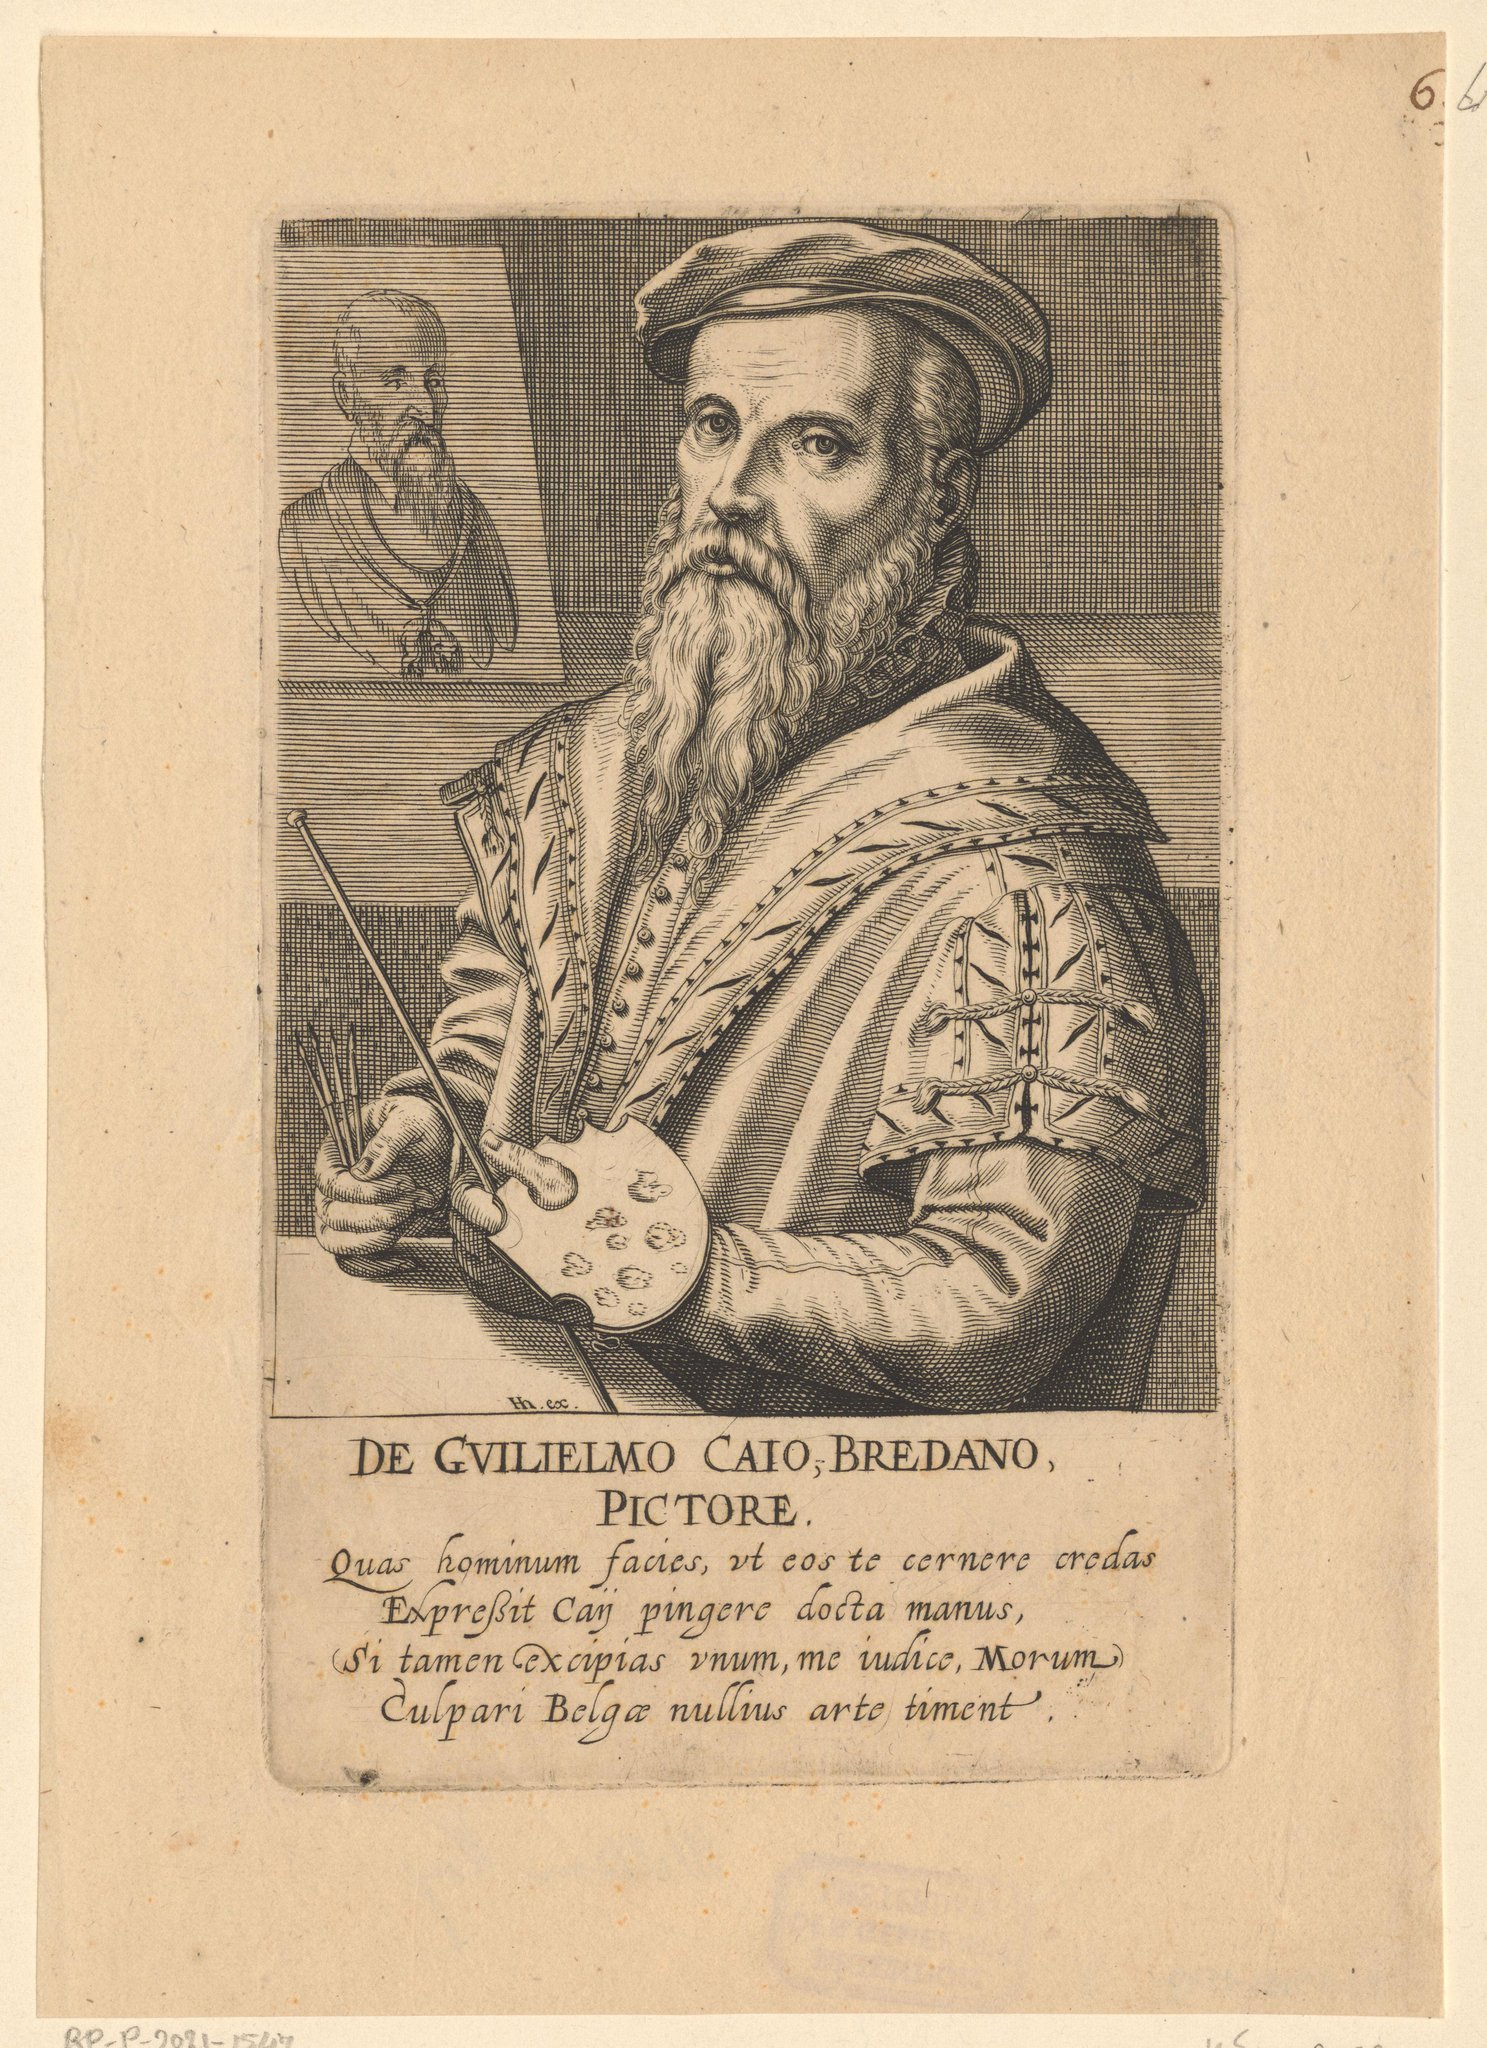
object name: print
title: Portretten van beroemde schilders uit de Lage Landen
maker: hendrick hondius (i)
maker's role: draughtsman, print maker, publisher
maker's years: 1573-1650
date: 1610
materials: paper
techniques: engraving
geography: the hague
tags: antwerp, painter, willem key, historical persons, portrait, self-portrait of painter, tools, implements of painter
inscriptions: collector's mark: Lugt 11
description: Prent uit deel één van de serie Pictorum Aliquot Celebrium Praecipuae Germaniae Inferioris Effigies. De serie van 72 kunstenaarsportretten is vervaardigd door Hendrick Hondius I, Simon Frisius, Andries Jacobsz. Stock en Robert de Baudous.